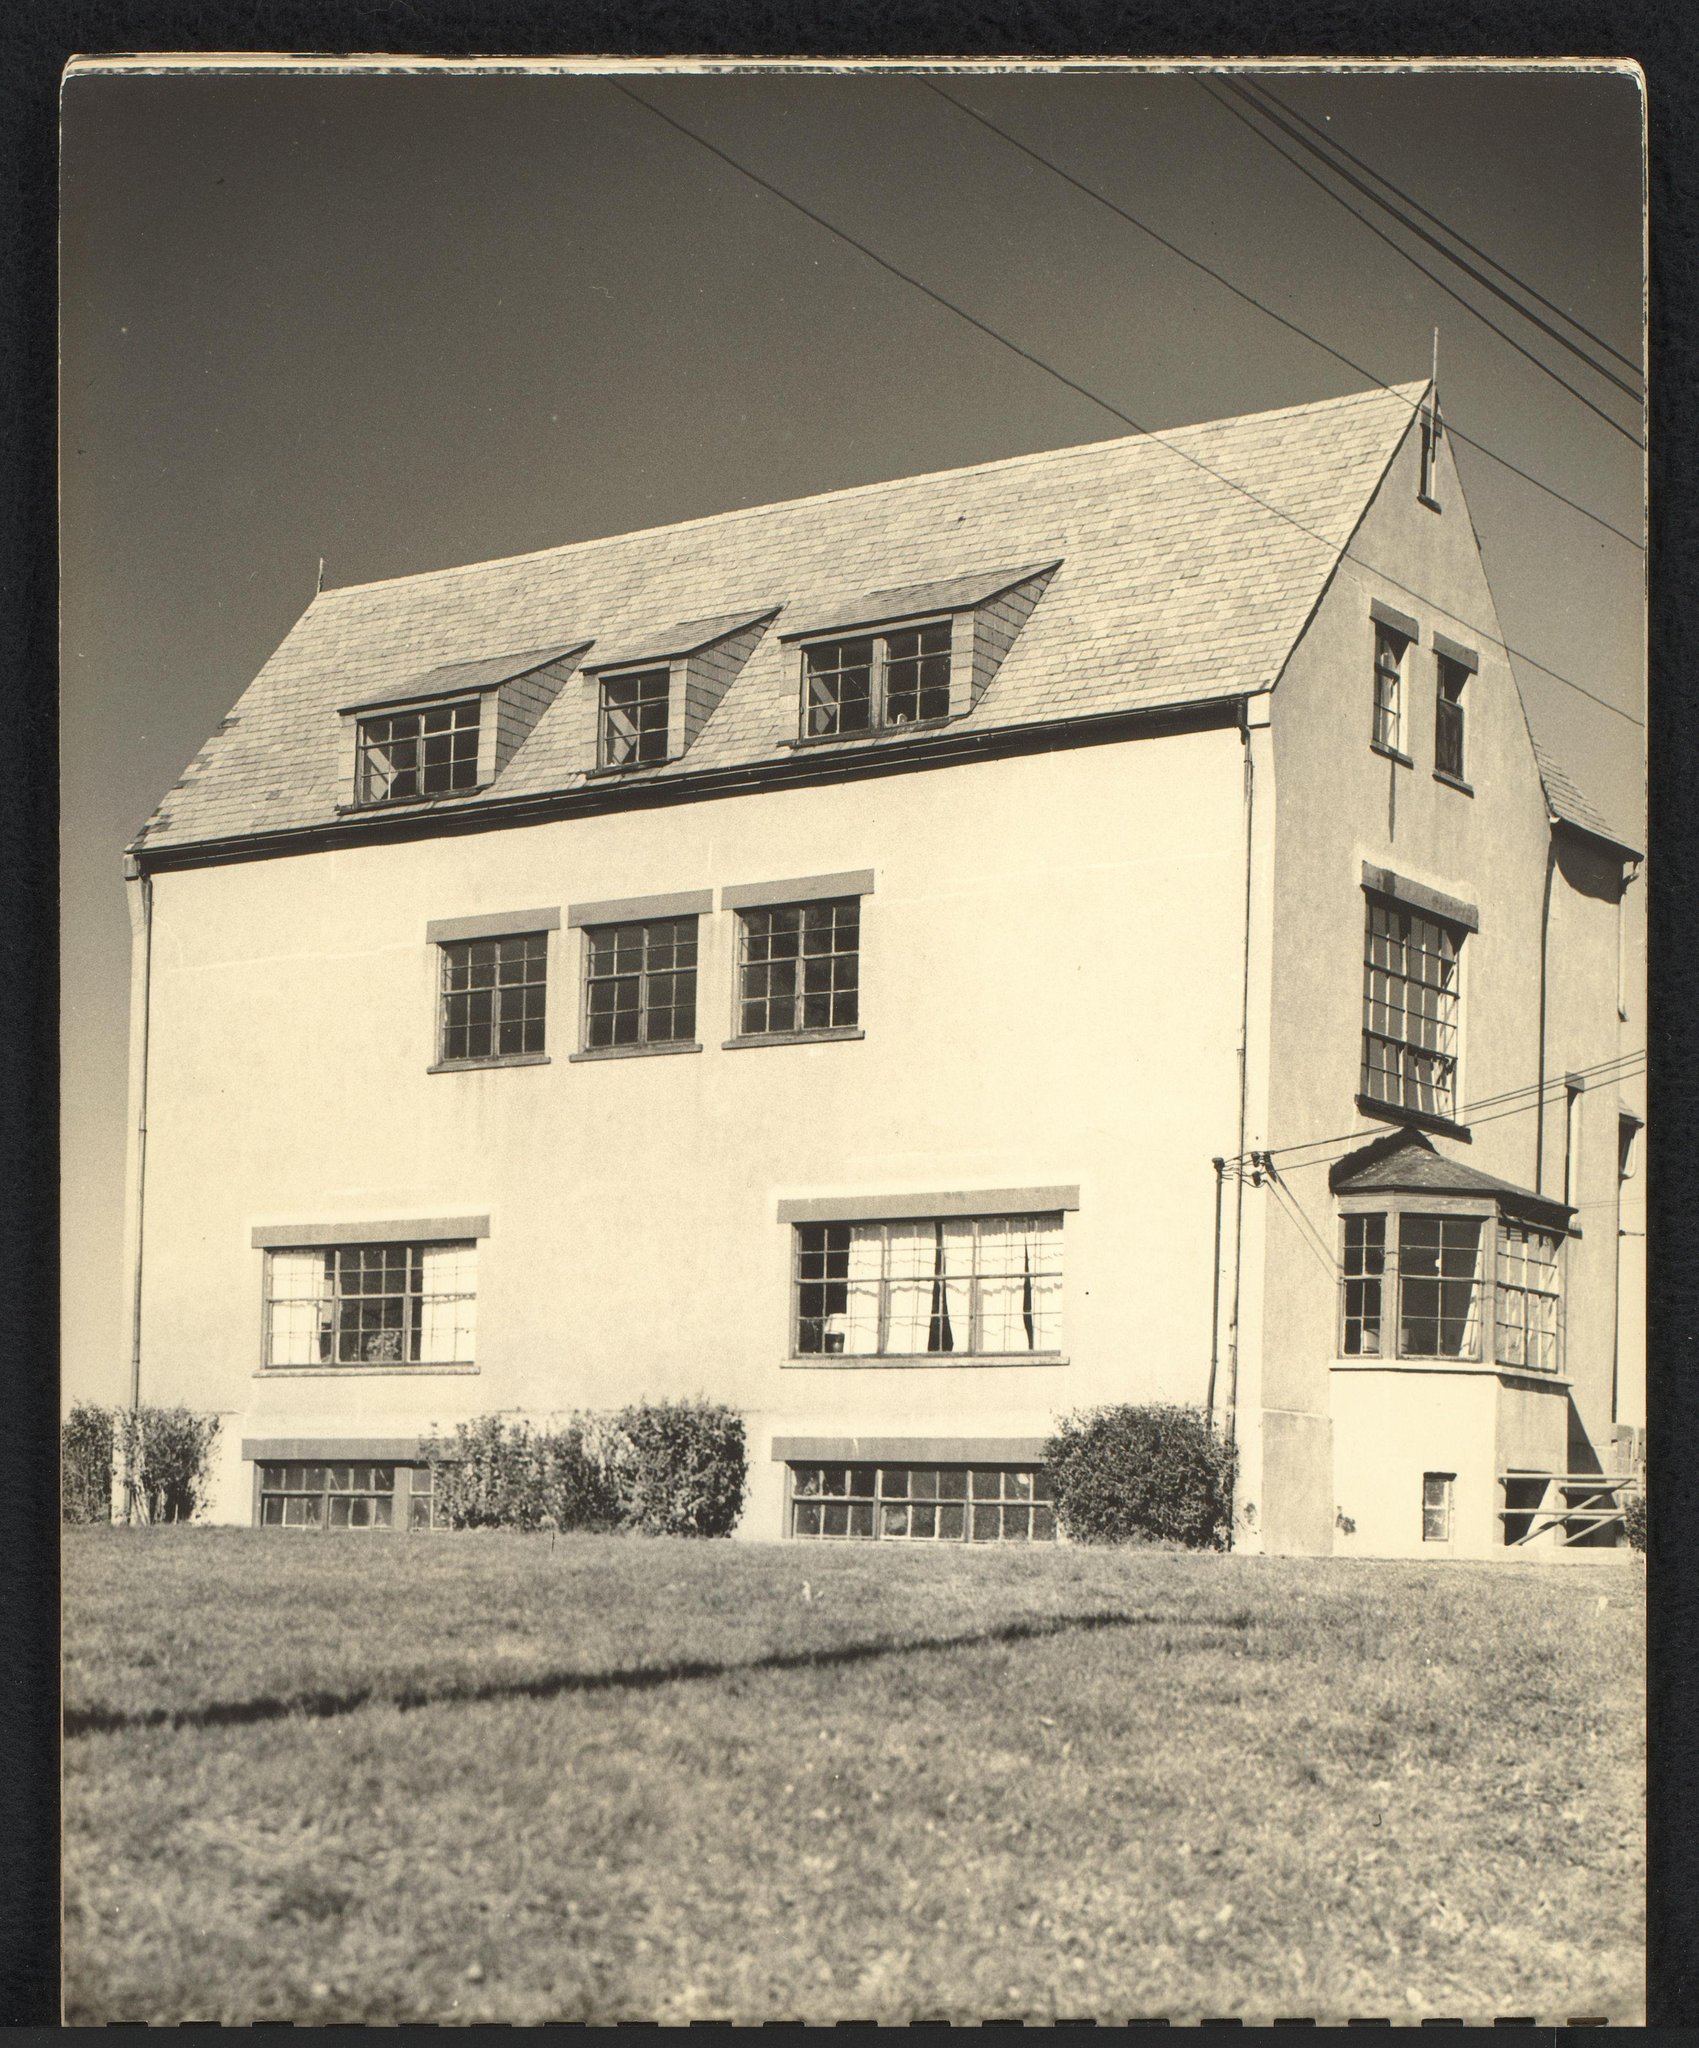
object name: photograph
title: White Cottage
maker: Anonymous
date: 1950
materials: paper, photographic support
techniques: gelatin silver print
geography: new york city